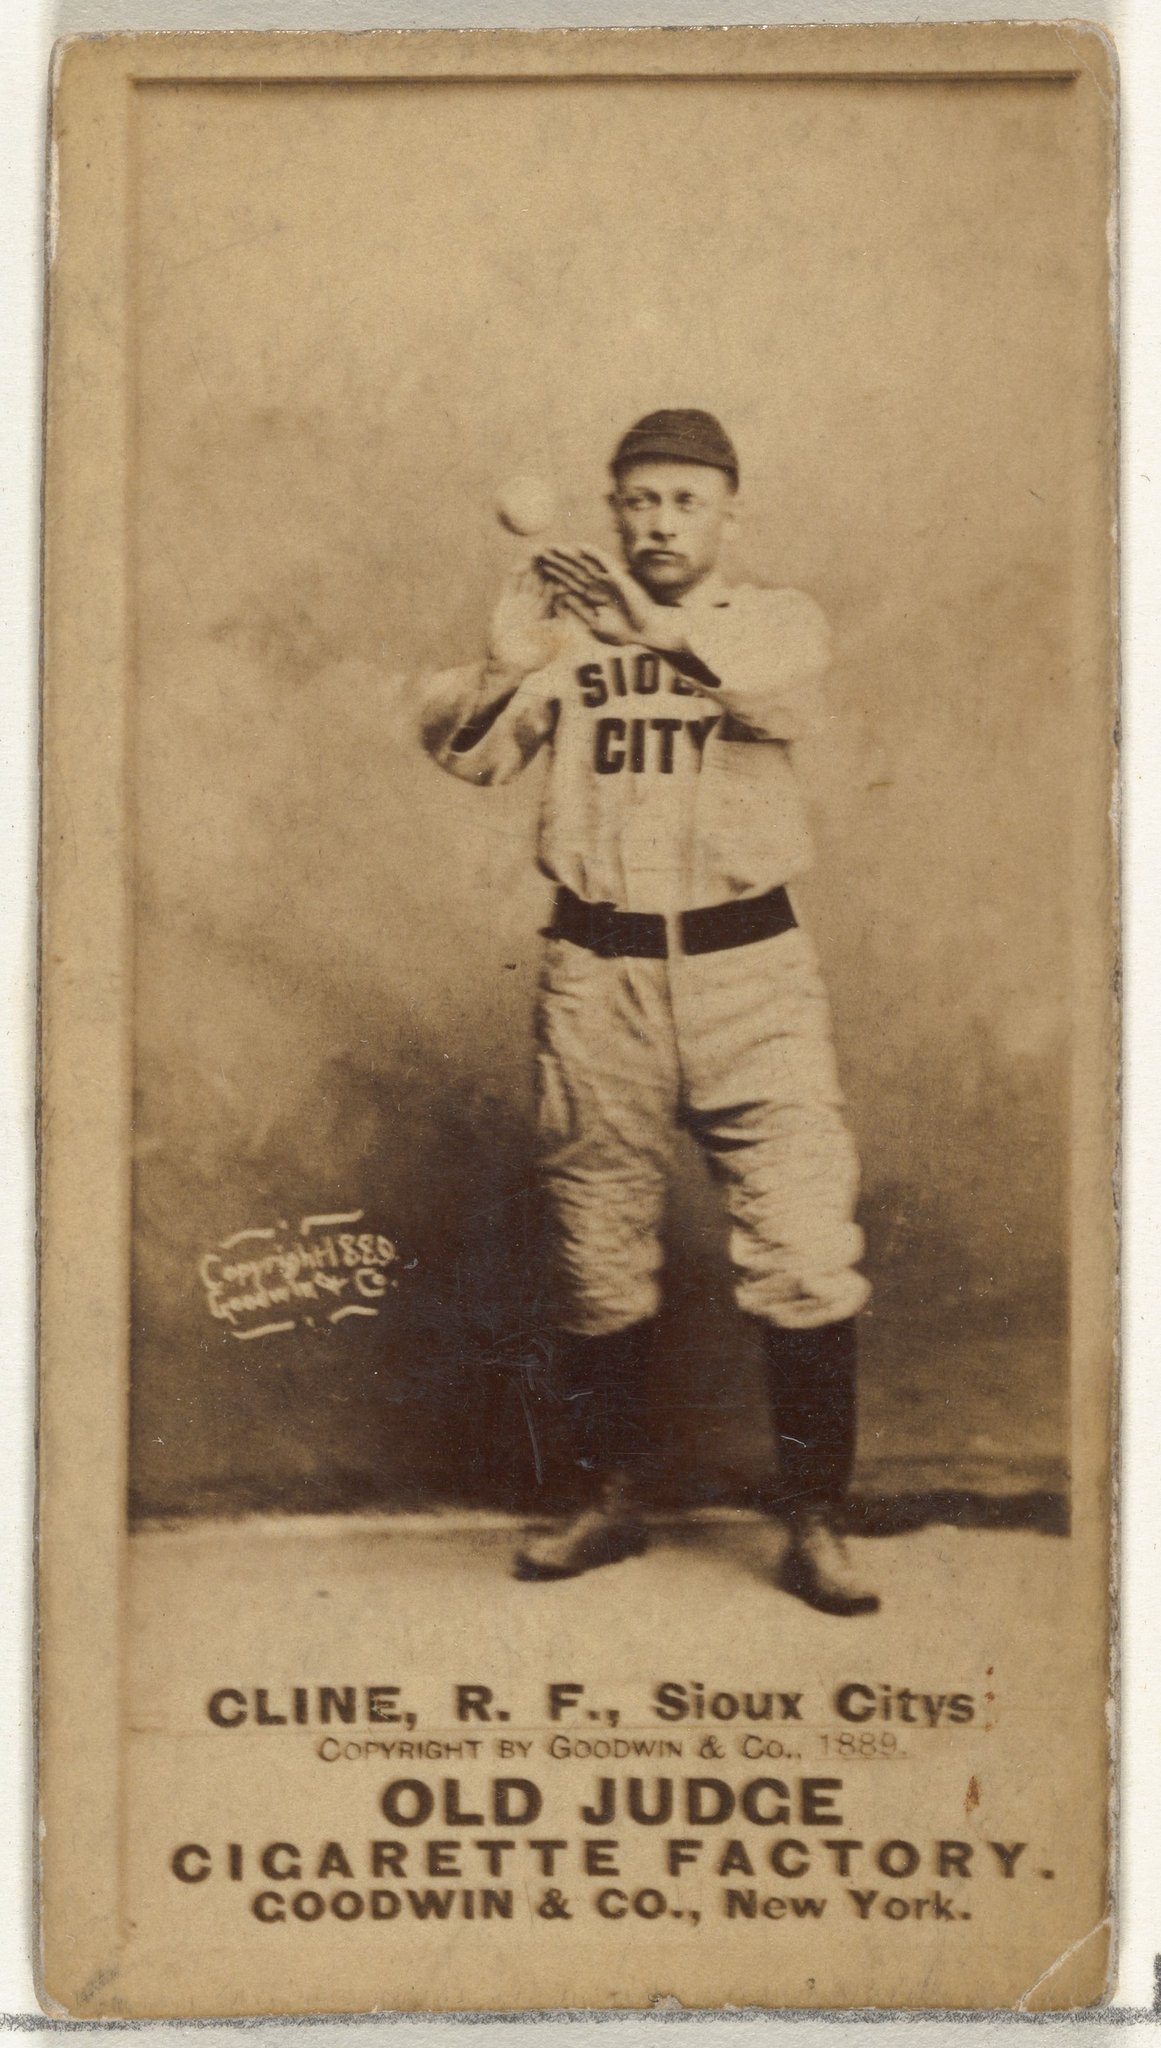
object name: baseball card, photograph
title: John P. "Monk" Cline, Right Field, Sioux City Corn Huskers, from the Old Judge series (N172) for Old Judge Cigarettes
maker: goodwin & company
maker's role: publisher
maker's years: 1850-1950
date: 1889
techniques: albumen silver print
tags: men,portraits,baseball,athletes